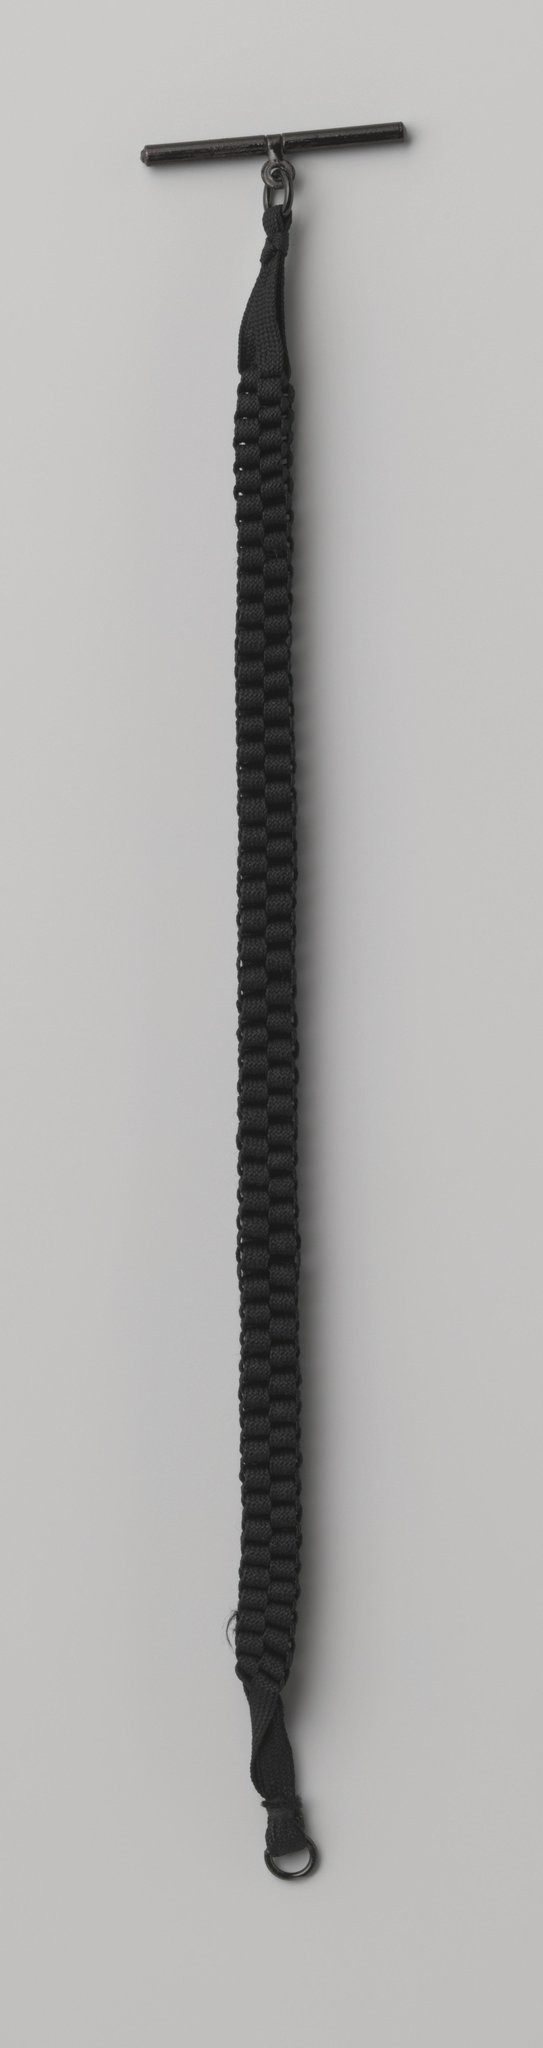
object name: mourning jewelry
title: Chatelaine van zwart in een vierkant gevlochten garen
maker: Anonymous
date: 1880-1900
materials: metal, textile, yarns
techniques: braiding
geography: europe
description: Chatelaine van zwart in een vierkant gevlochten garen.